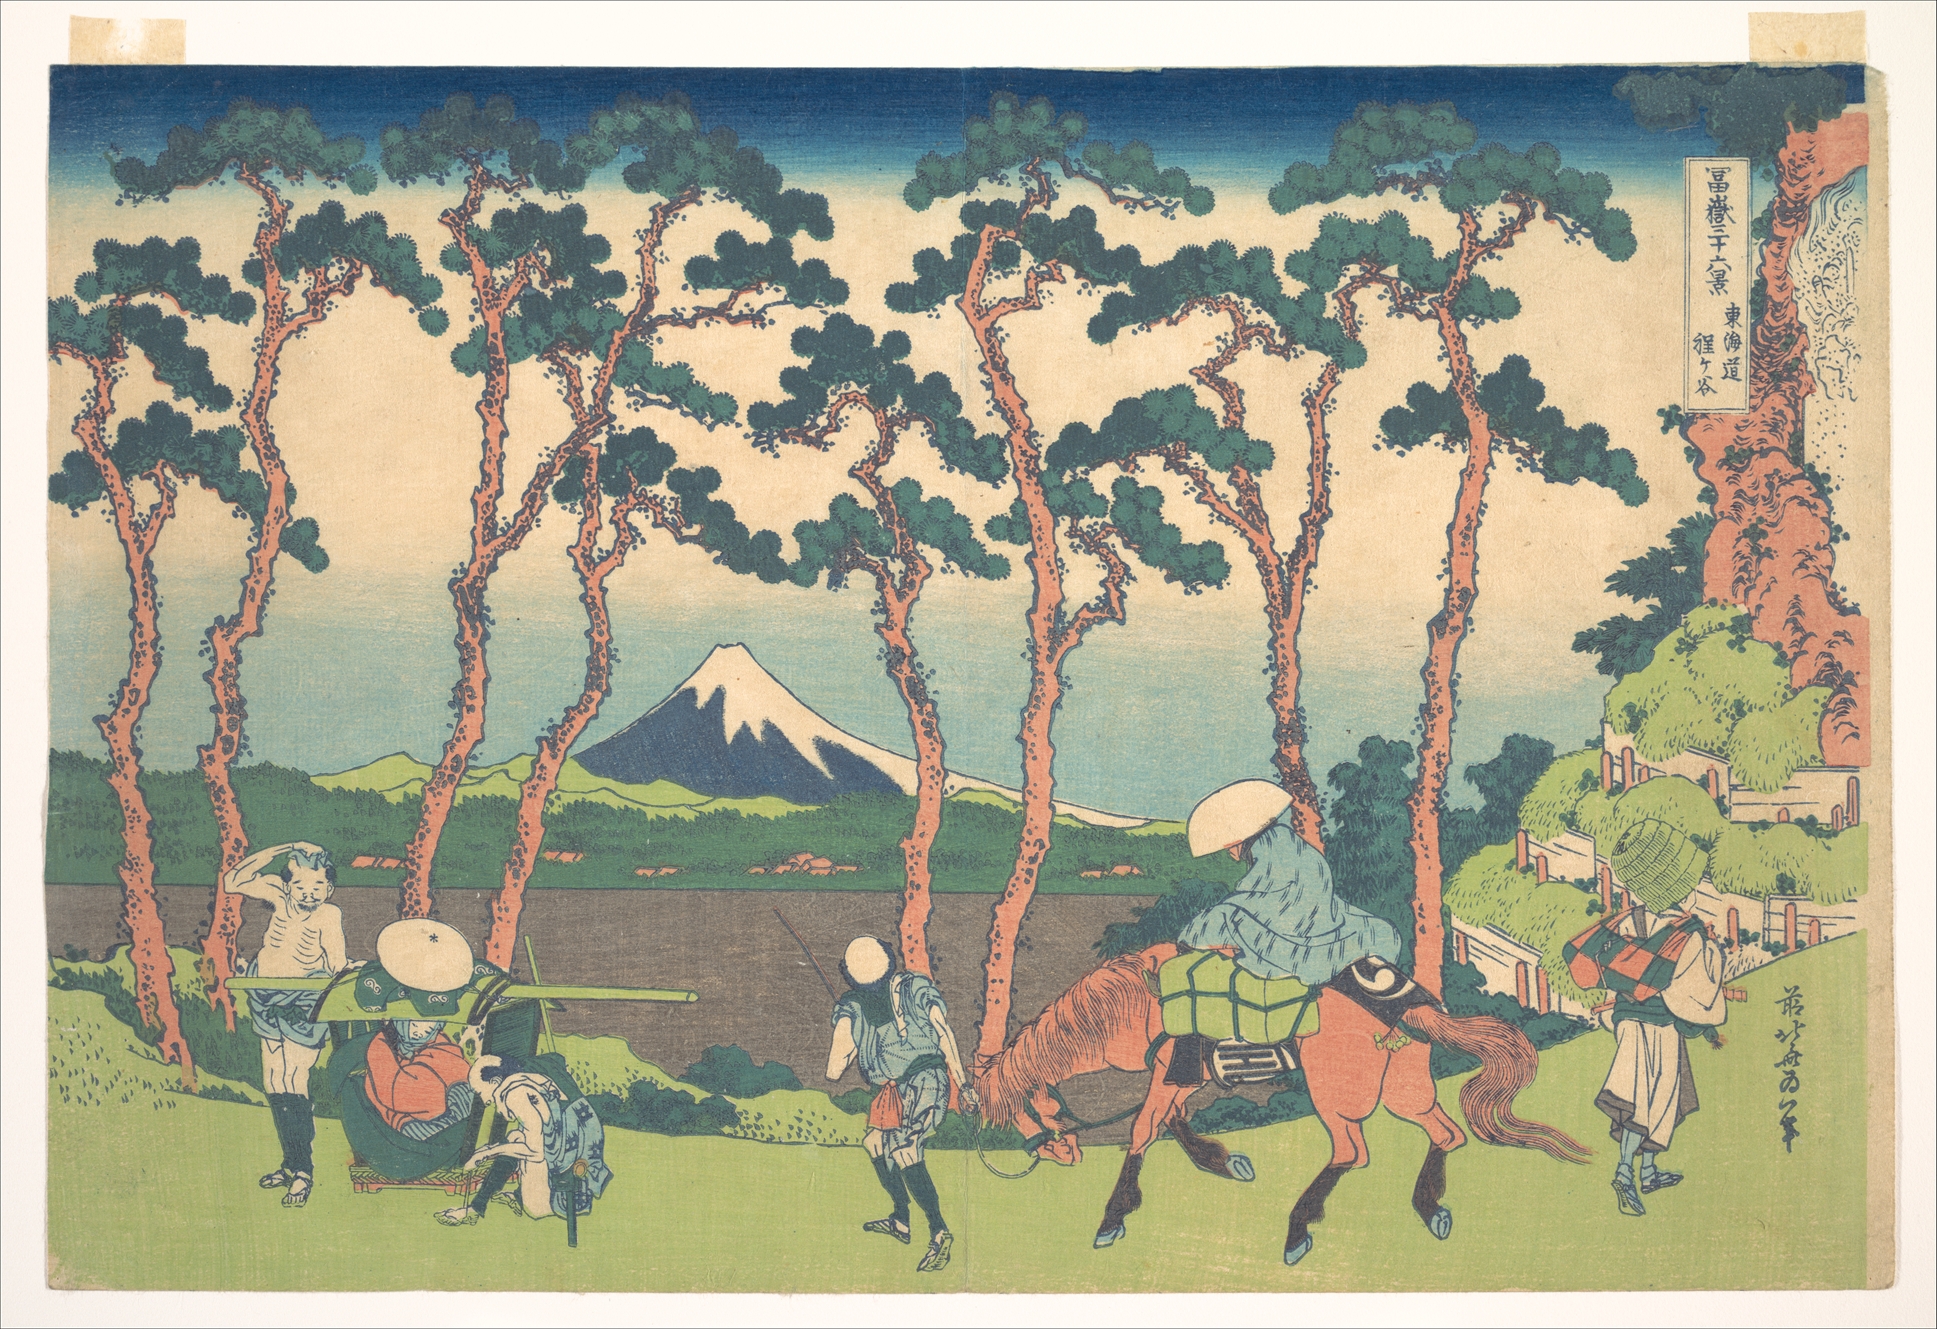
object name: woodblock print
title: Hodogaya on the Tōkaidō (Tōkaidō Hodogaya), from the series Thirty-six Views of Mount Fuji (Fugaku sanjūrokkei)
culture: japanese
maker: katsushika hokusai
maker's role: artist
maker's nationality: japanese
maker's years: 1760-1849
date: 1830-1832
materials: ink, paper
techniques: woodblock print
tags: human figures,horses,volcanoes,trees